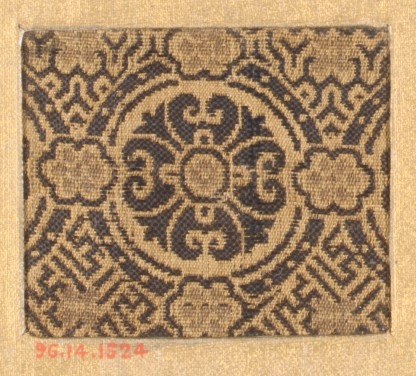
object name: piece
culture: japanese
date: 1701-1900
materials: silk